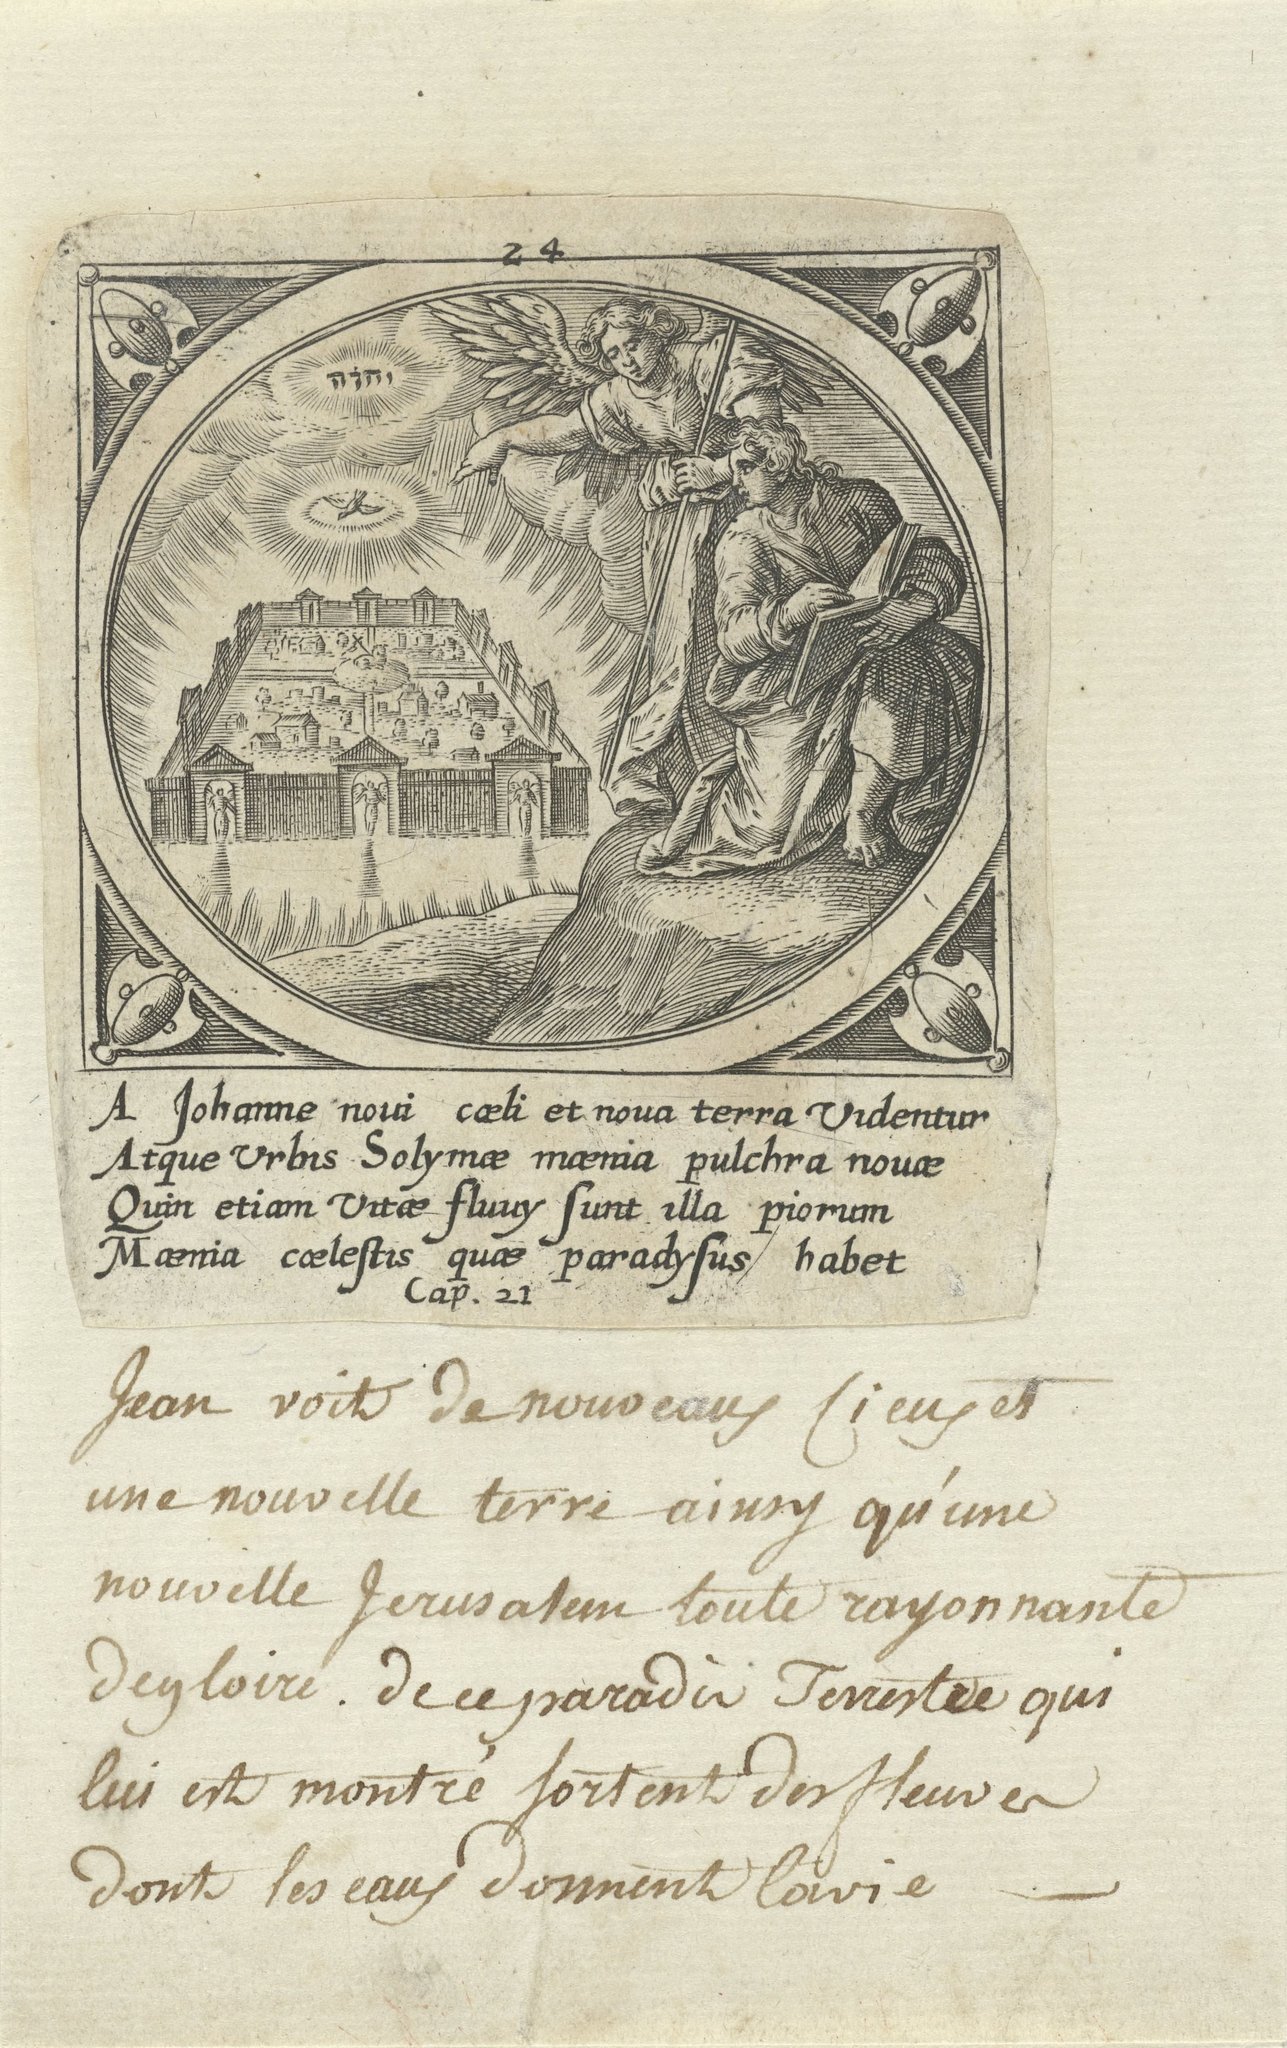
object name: print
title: Icones Revelationum S Johs Evangeliste in Pathmo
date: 1585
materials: paper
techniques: engraving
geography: antwerp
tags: an angel shows john the new (heavenly) jerusalem coming down from heaven; sometimes christ is shown leading his lambs to the city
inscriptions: collector's mark: Lugt 2228, inscription: ‘Jean voit [...] donnent louie.’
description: Een engel toont Johannes het nieuwe (hemelse) Jeruzalem. Johannes schrijft in een boek. Boven de stad de Heilige Geest (als duif) en een tetragram. In de marge een vierregelig onderschrift in het Latijn. Vierentwintigste prent uit een serie van vierentwintig met de openbaring van Johannes op Patmos.